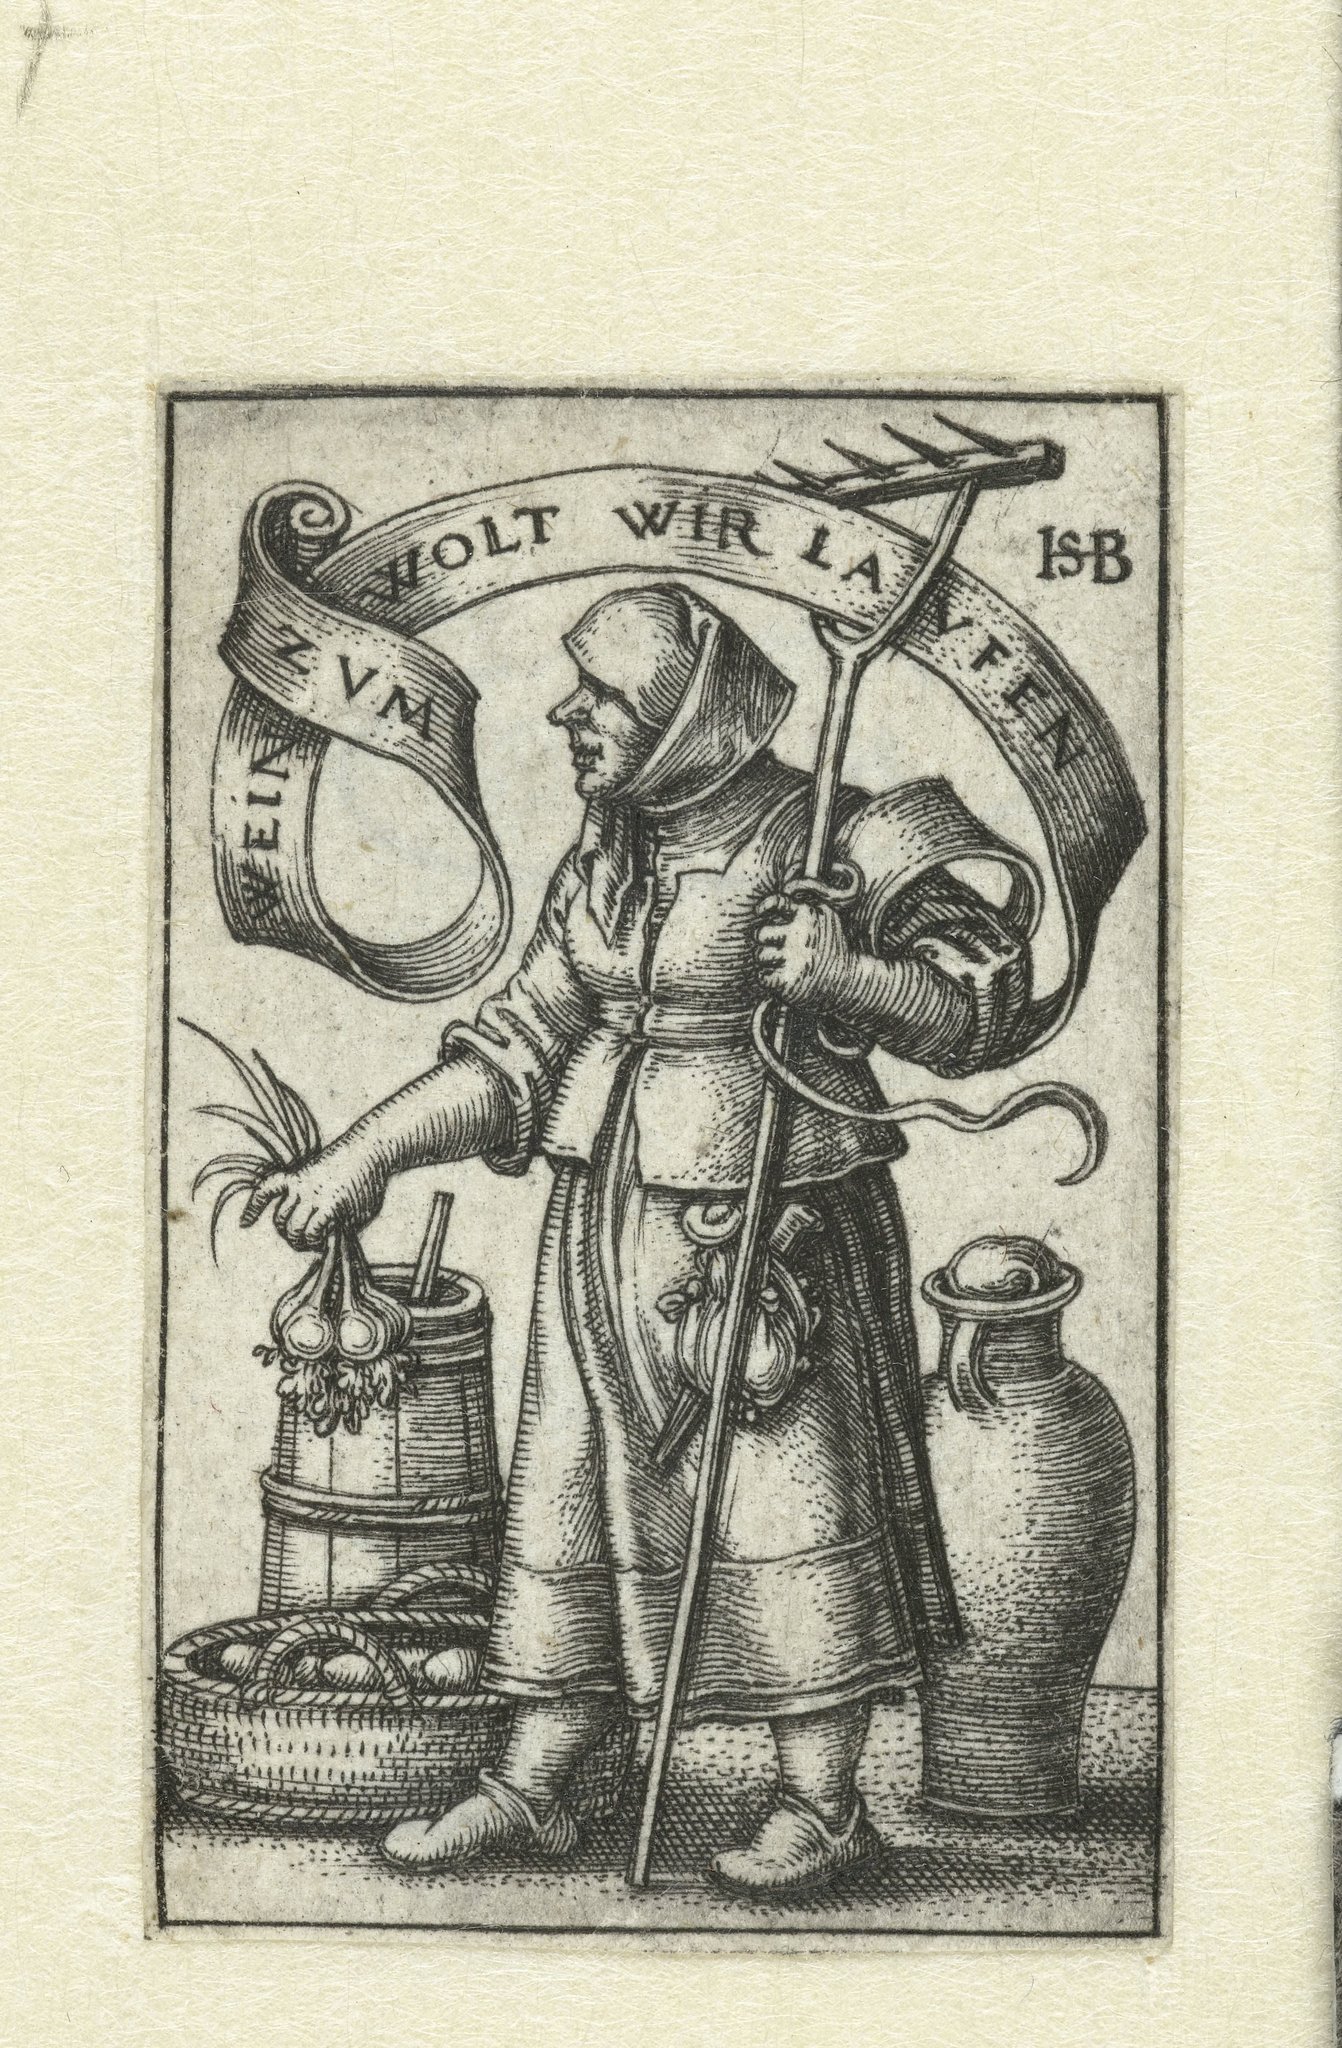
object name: print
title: Zum wein wolt wir lavfen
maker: hans sebald beham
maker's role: designer, draughtsman, print maker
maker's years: 1500-1550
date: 1510-1550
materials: paper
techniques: engraving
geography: germany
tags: merchant, salesman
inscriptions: collector's mark:, collector's mark: Lugt 2228a, collector's mark: Lugt 2760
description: Dit prentje met een boerin die haar produkten verkoopt op de markt heeft een pendant met een boer die zijn waren heeft uitgestald. De figuren zijn naar elkaar toegewend weergegeven met de titels op tekstbanden welke volledig geïntegreerd zijn met de figuren en hun attributen. De teksten vullen elkaar aan en zijn moralistisch bedoeld, de boer en boerin verkopen hun produkten maar de opbrengst gaat op aan drank.